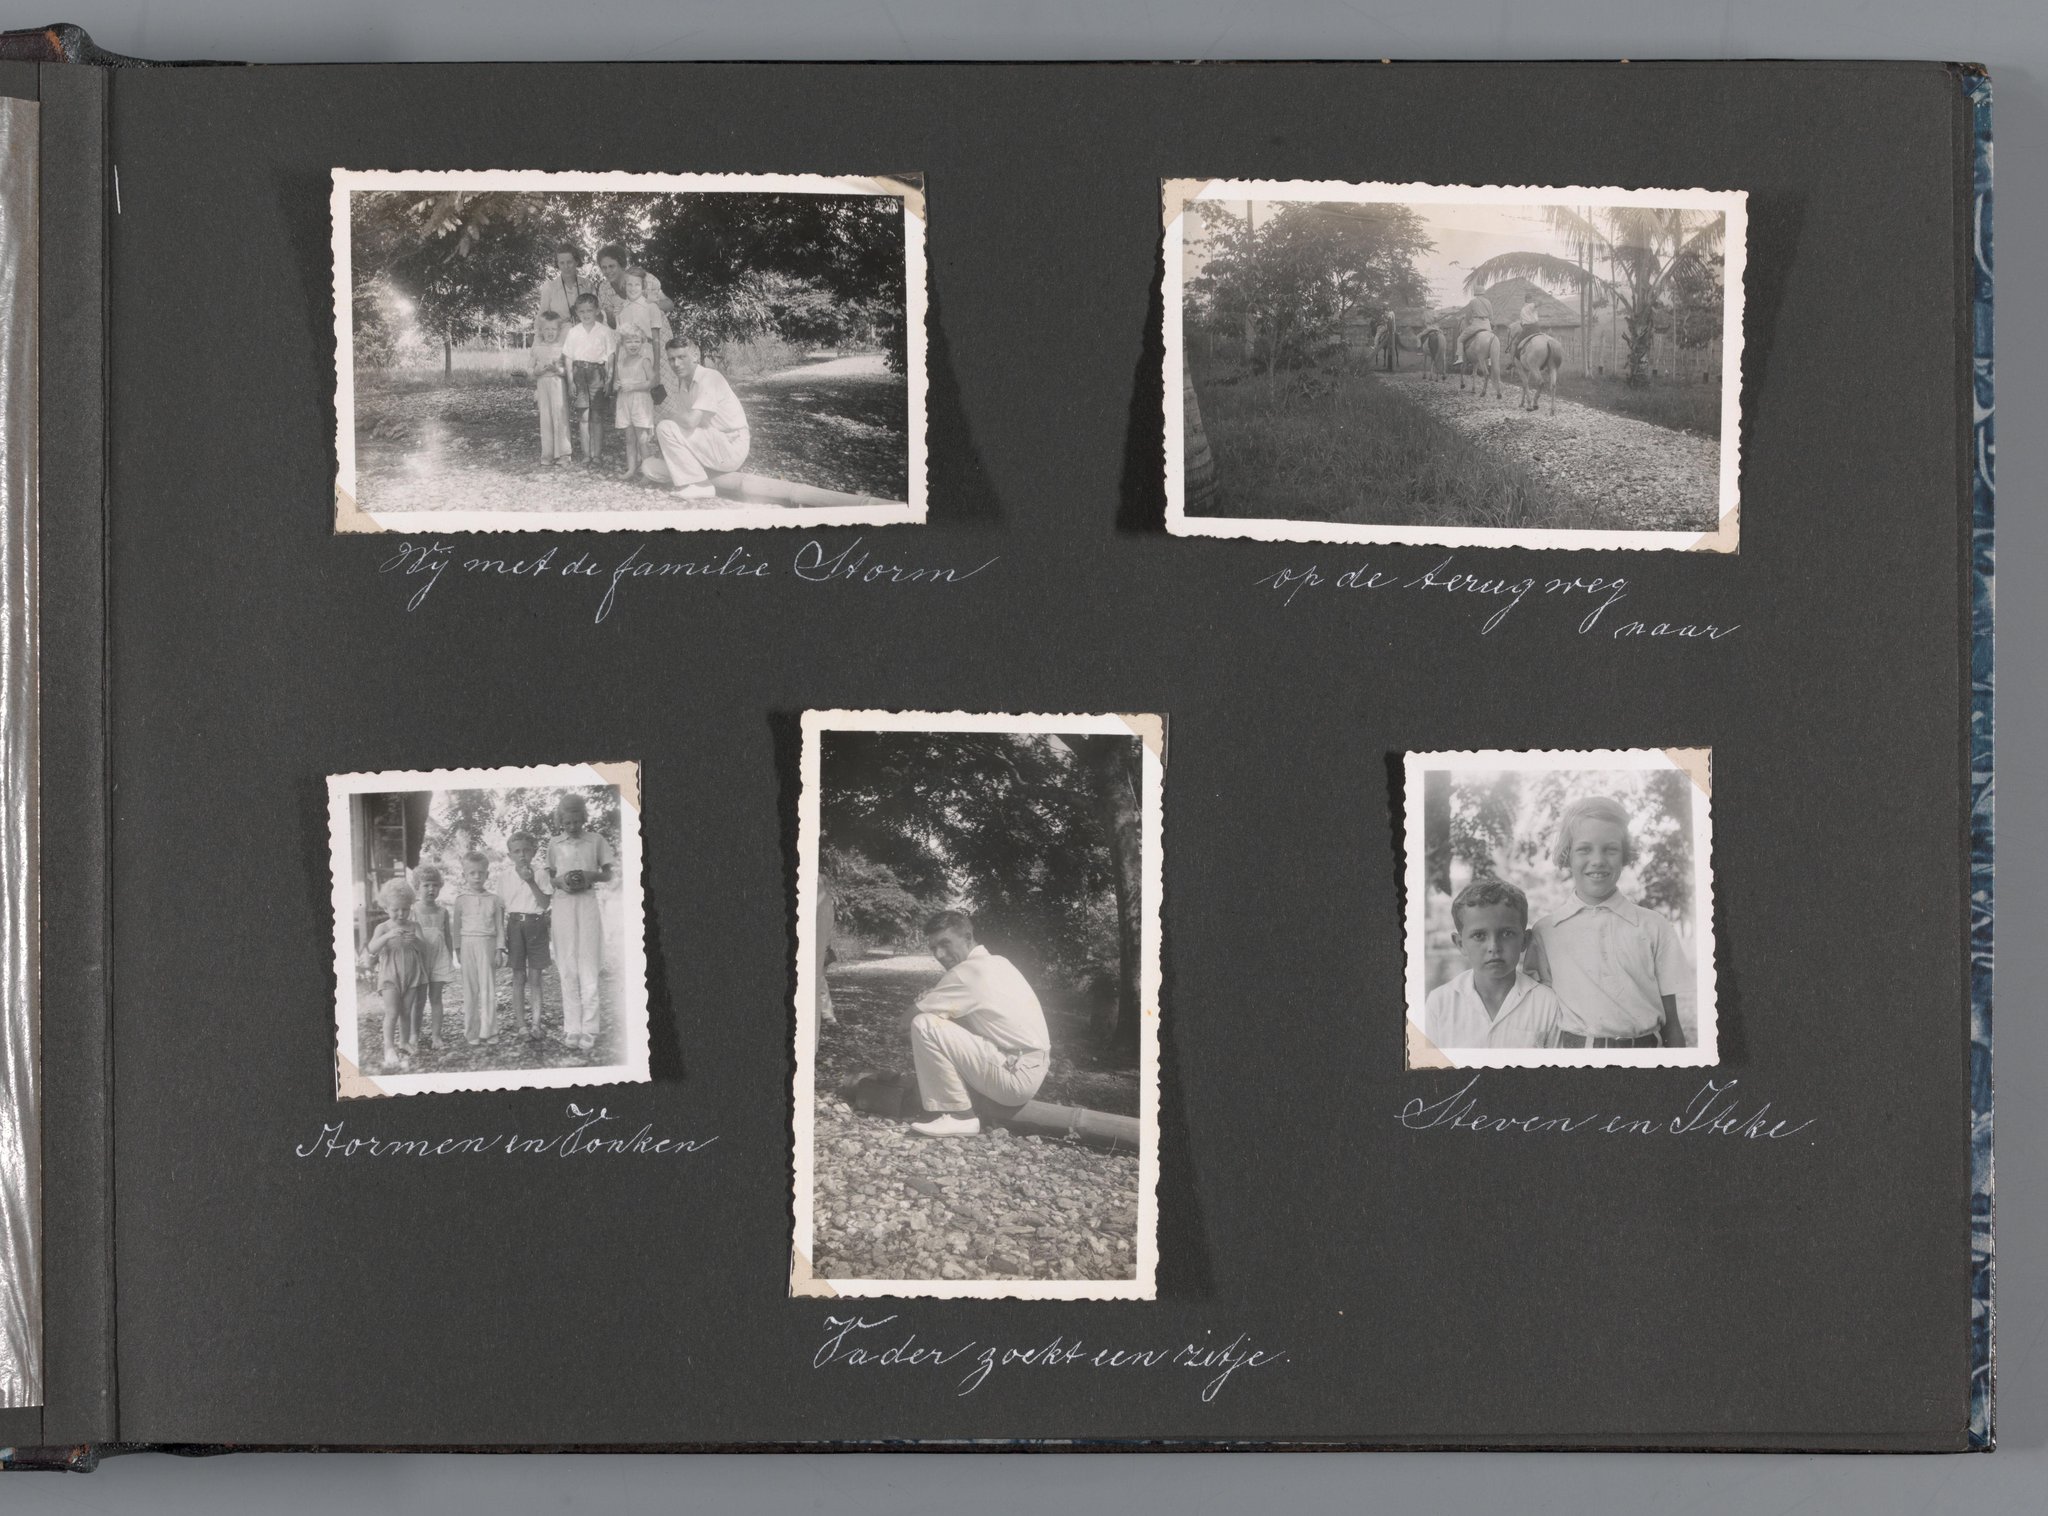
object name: album leaf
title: Familiefoto's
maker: Anonymous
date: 1935-1938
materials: cardboard, photographic support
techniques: gelatin silver print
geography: celebes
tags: jet vonk, r.h. vonk, family life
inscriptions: inscription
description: Albumblad met vijf foto's van de familie Vonk en hun vrienden de familie Storm. Onderdeel van het familiealbum van Jet Vonk uit Celebes.